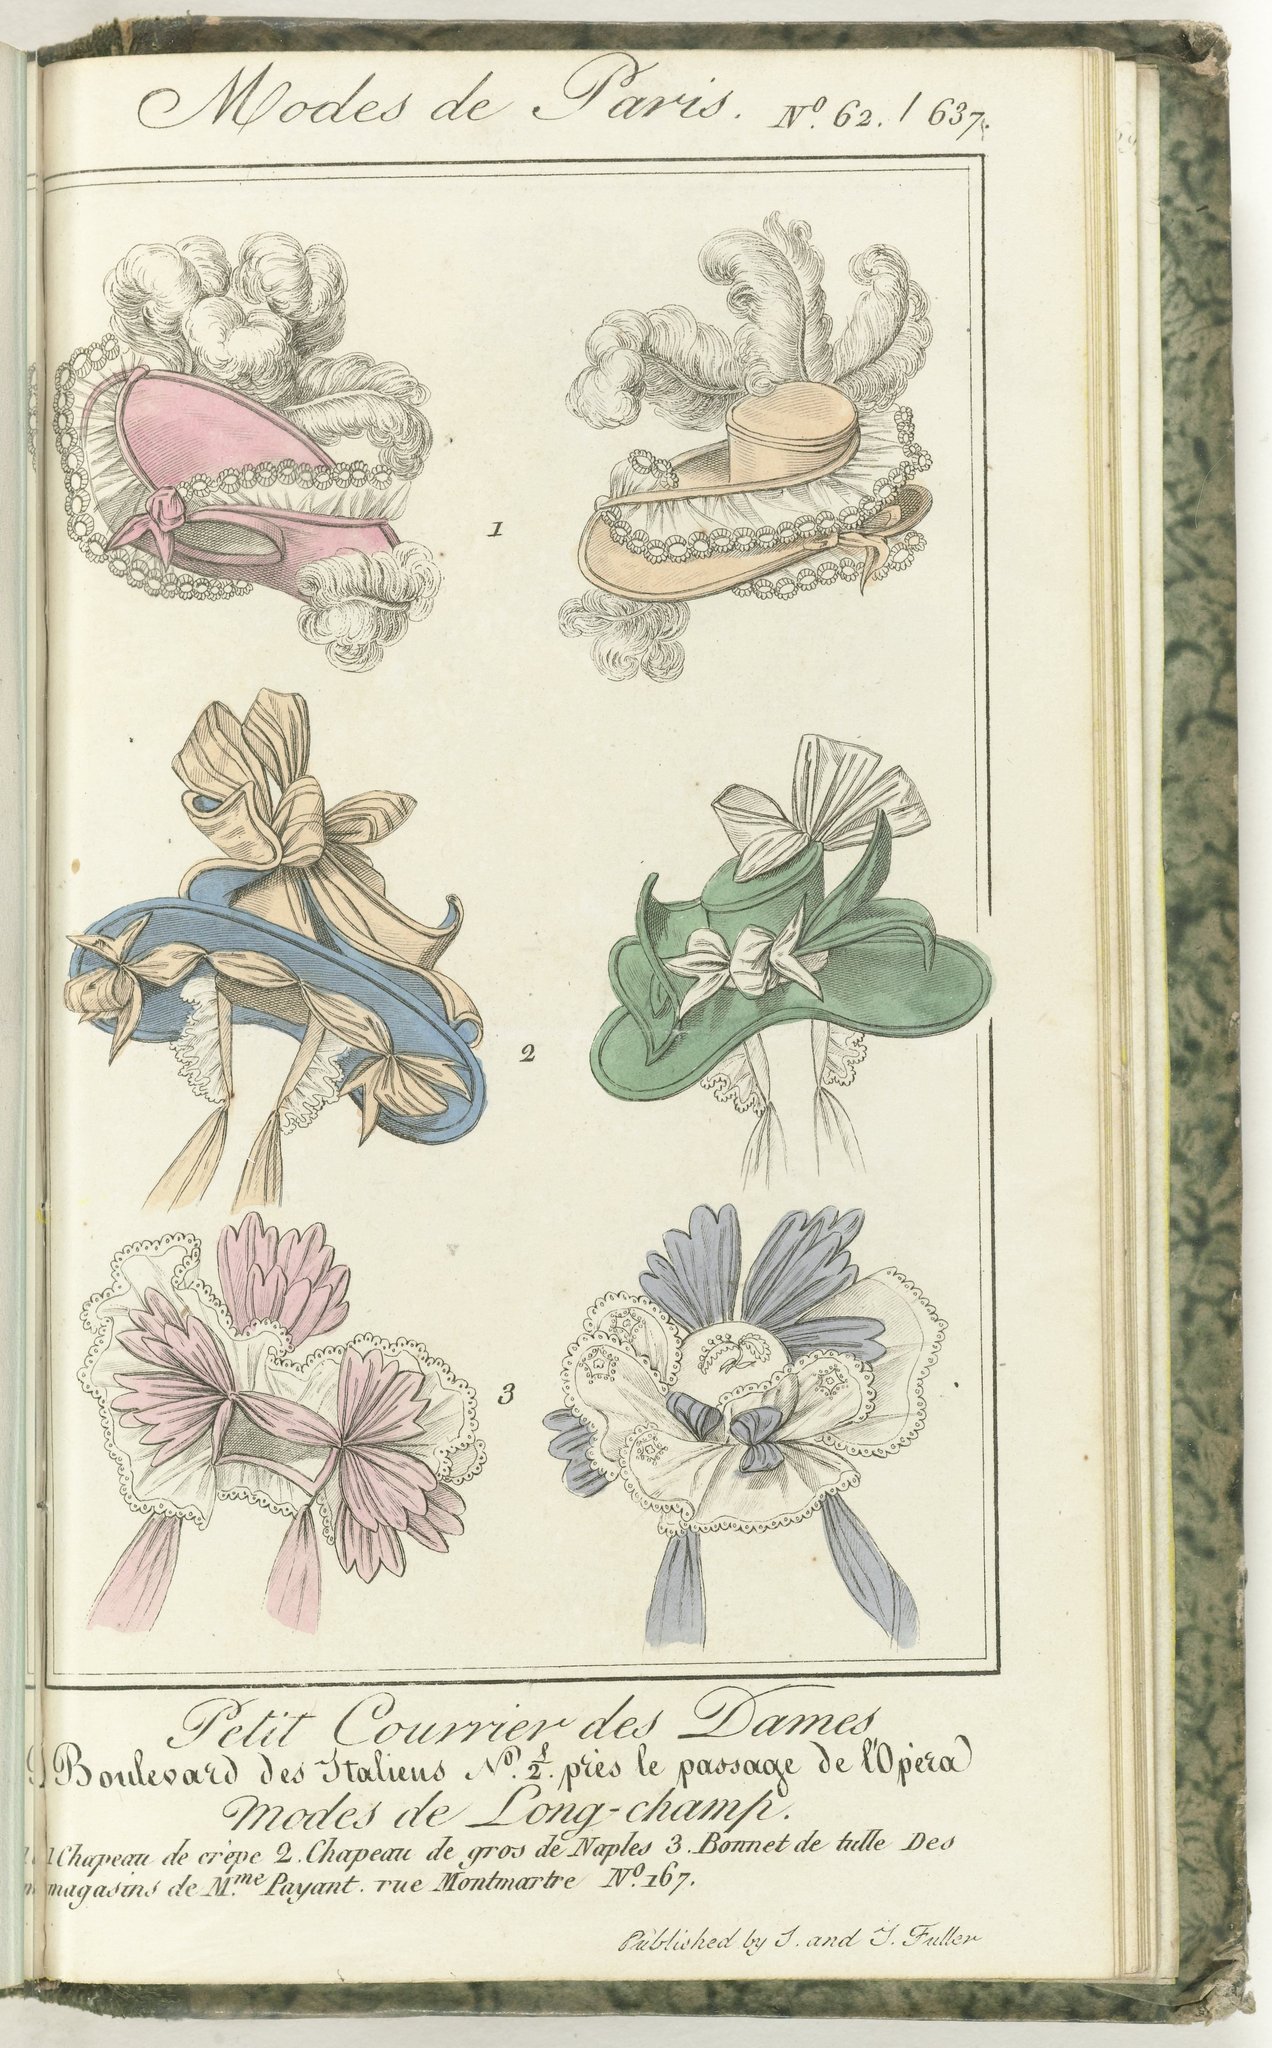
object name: fashion print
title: Petit Courrier des Dames, 10 mai 1829, No. 42 / 637 : Modes de Long-champ...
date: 1829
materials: paper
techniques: engraving, hand coloring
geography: paris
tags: head-gear: cap (+ women's clothes), fashion plates, head-gear: hat (+ women's clothes)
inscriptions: title: ‘Modes de Paris.’, inscription: ‘Published by S. and J. Fuller’, caption: ‘Modes de Long-champ. / Chapeau de crèpe 2. Chapeau de gros de Naples 3. Bonnet de tulle Des Magasins de M.me Payant. rue Montmartre No. 167.’, address: ‘Boulevard des Italiens No.2 près le passage de l'Opèra.’, title: ‘Petit Courrier des Dames.’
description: 'Modes de Long-champ.' Drie verschillende hoofddeksels, van de voor- en achterzijde weergegeven, genummerd één tot en met drie. 1. Hoed van crêpe. 2. Hoed van 'gros de Naples'. 3. Muts van tule. Uit de winkels van Payant. Prent uit het modetijdschrift Petit Courrier des Dames (1821-1868). Ingebonden (met enkele pag. Le Journal des Dames et des Modes). 15 Januari 1827 t/m 20 maart 1830. Incompleet.